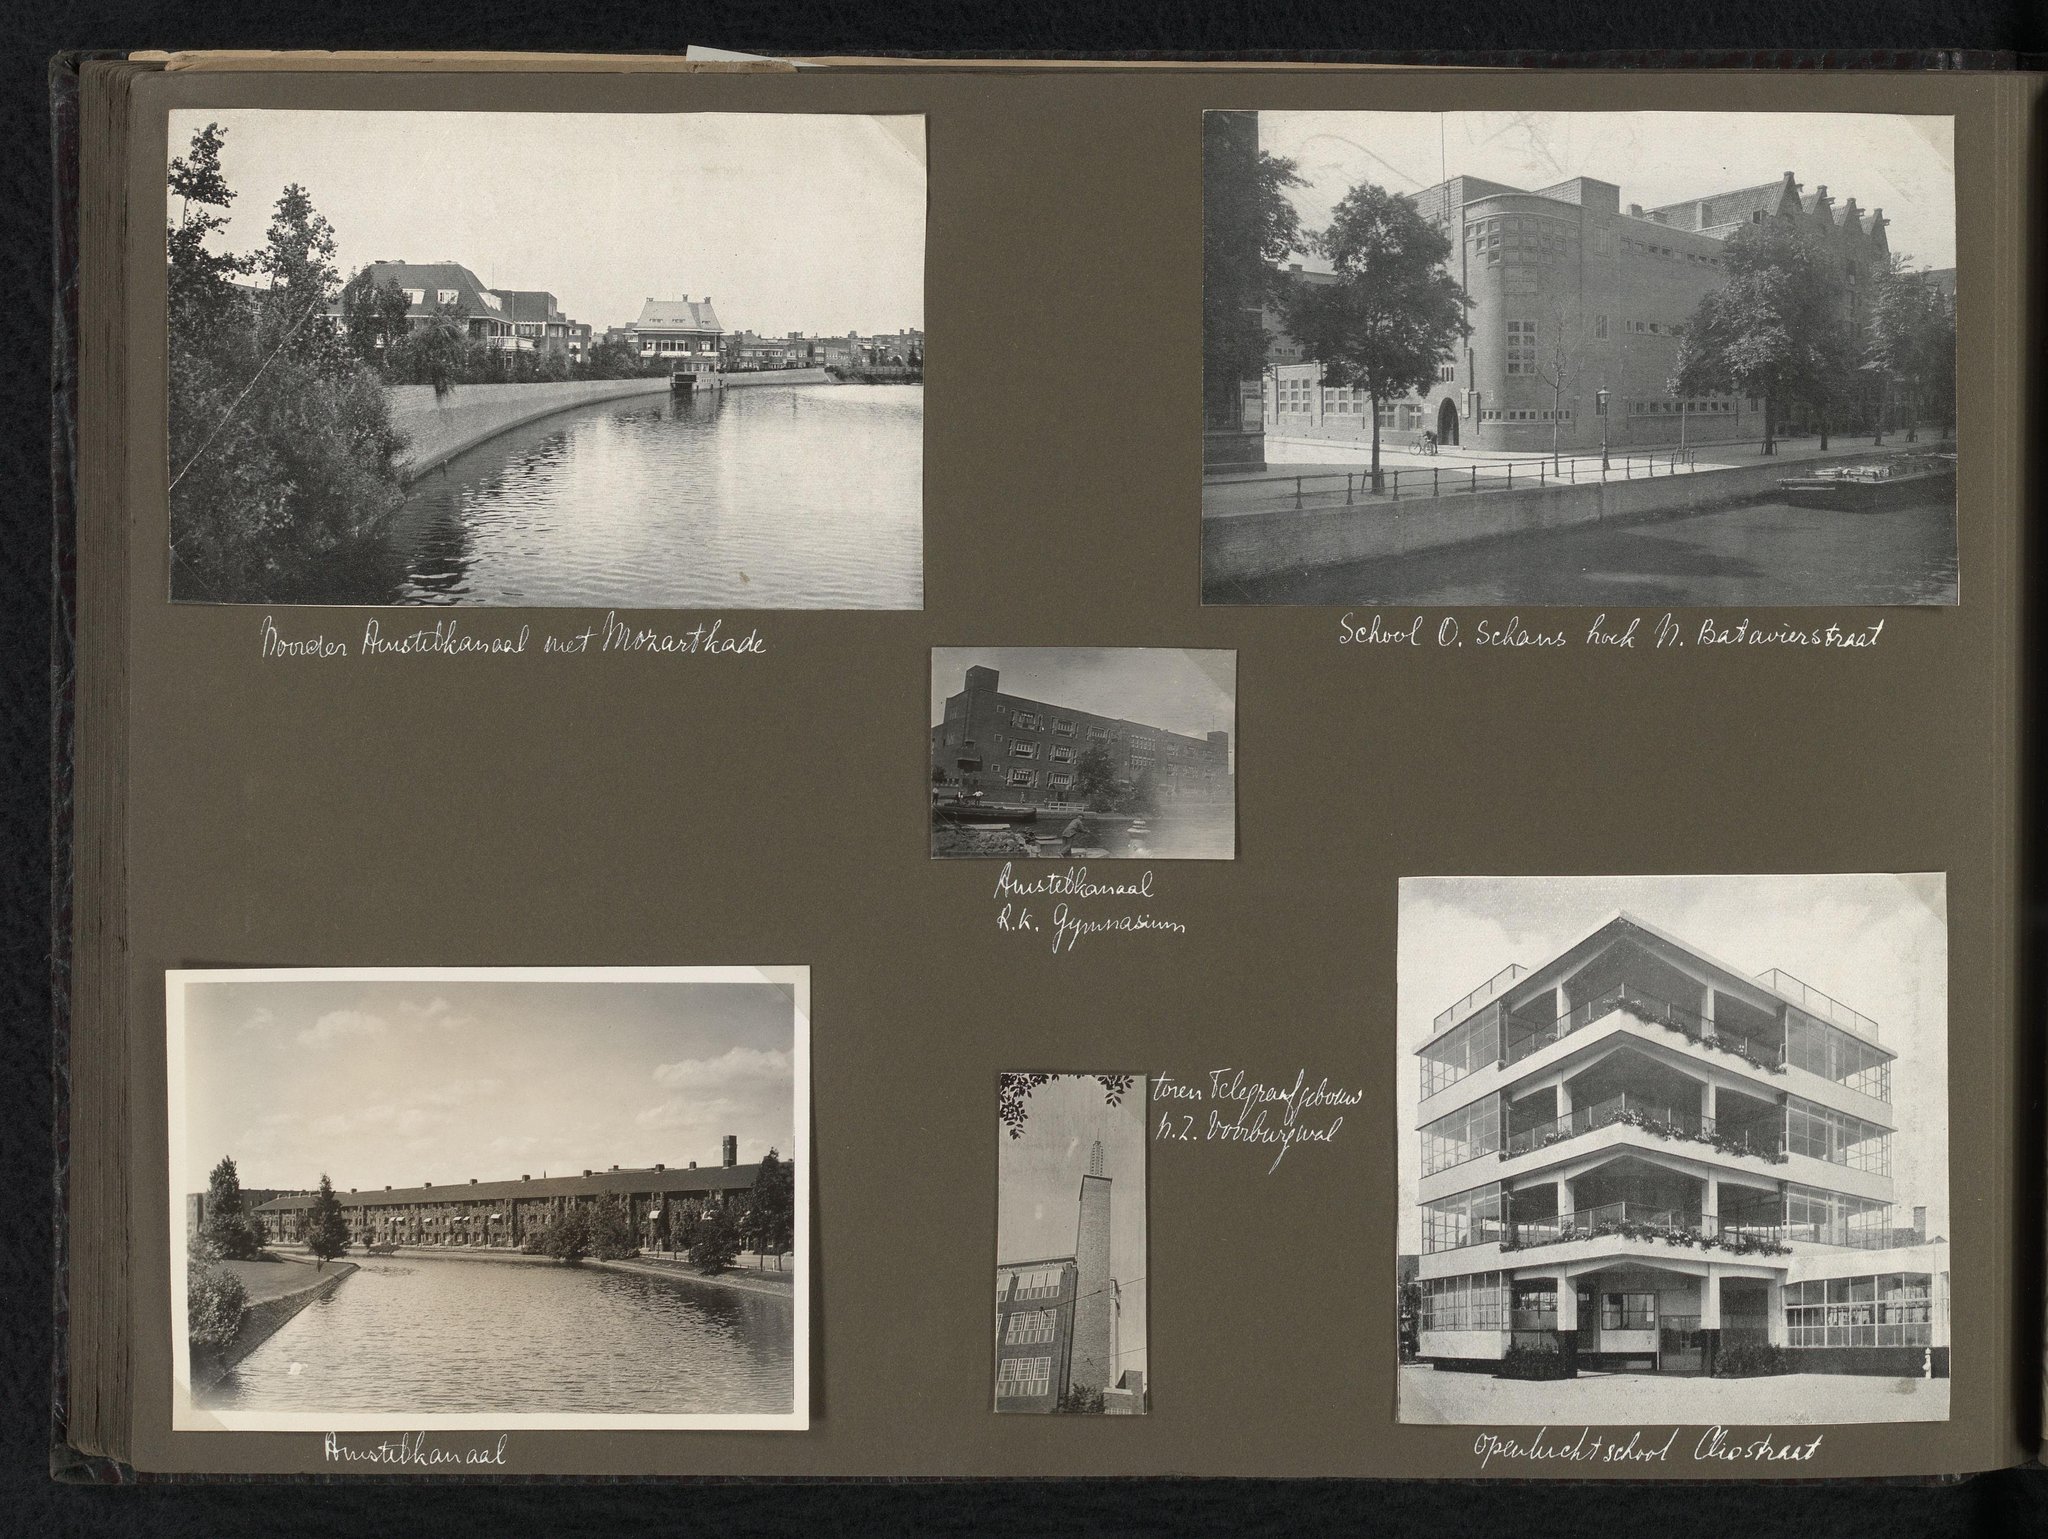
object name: photograph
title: Drie foto's en drie fotomechanische afdrukken van gebouwen in Amsterdam-Zuid en van het Telegraafgebouw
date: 1930-1931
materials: paper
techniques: gelatin silver print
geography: amsterdam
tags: urban housing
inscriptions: inscription: ‘Openluchtschool Cliostraat’, inscription: ‘Amstelkanaal’, inscription: ‘toren Telegraafgebouw/ N.Z. Voorburgwal’, inscription: ‘Noorden Amstelkanaal met Mozartkade’, inscription: ‘Amstelkanaal/ R.K. Gymnasium’, inscription: ‘School O. Schans hoek N. Batavierstraat’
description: Deze foto's en prenten maken deel uit van een album.